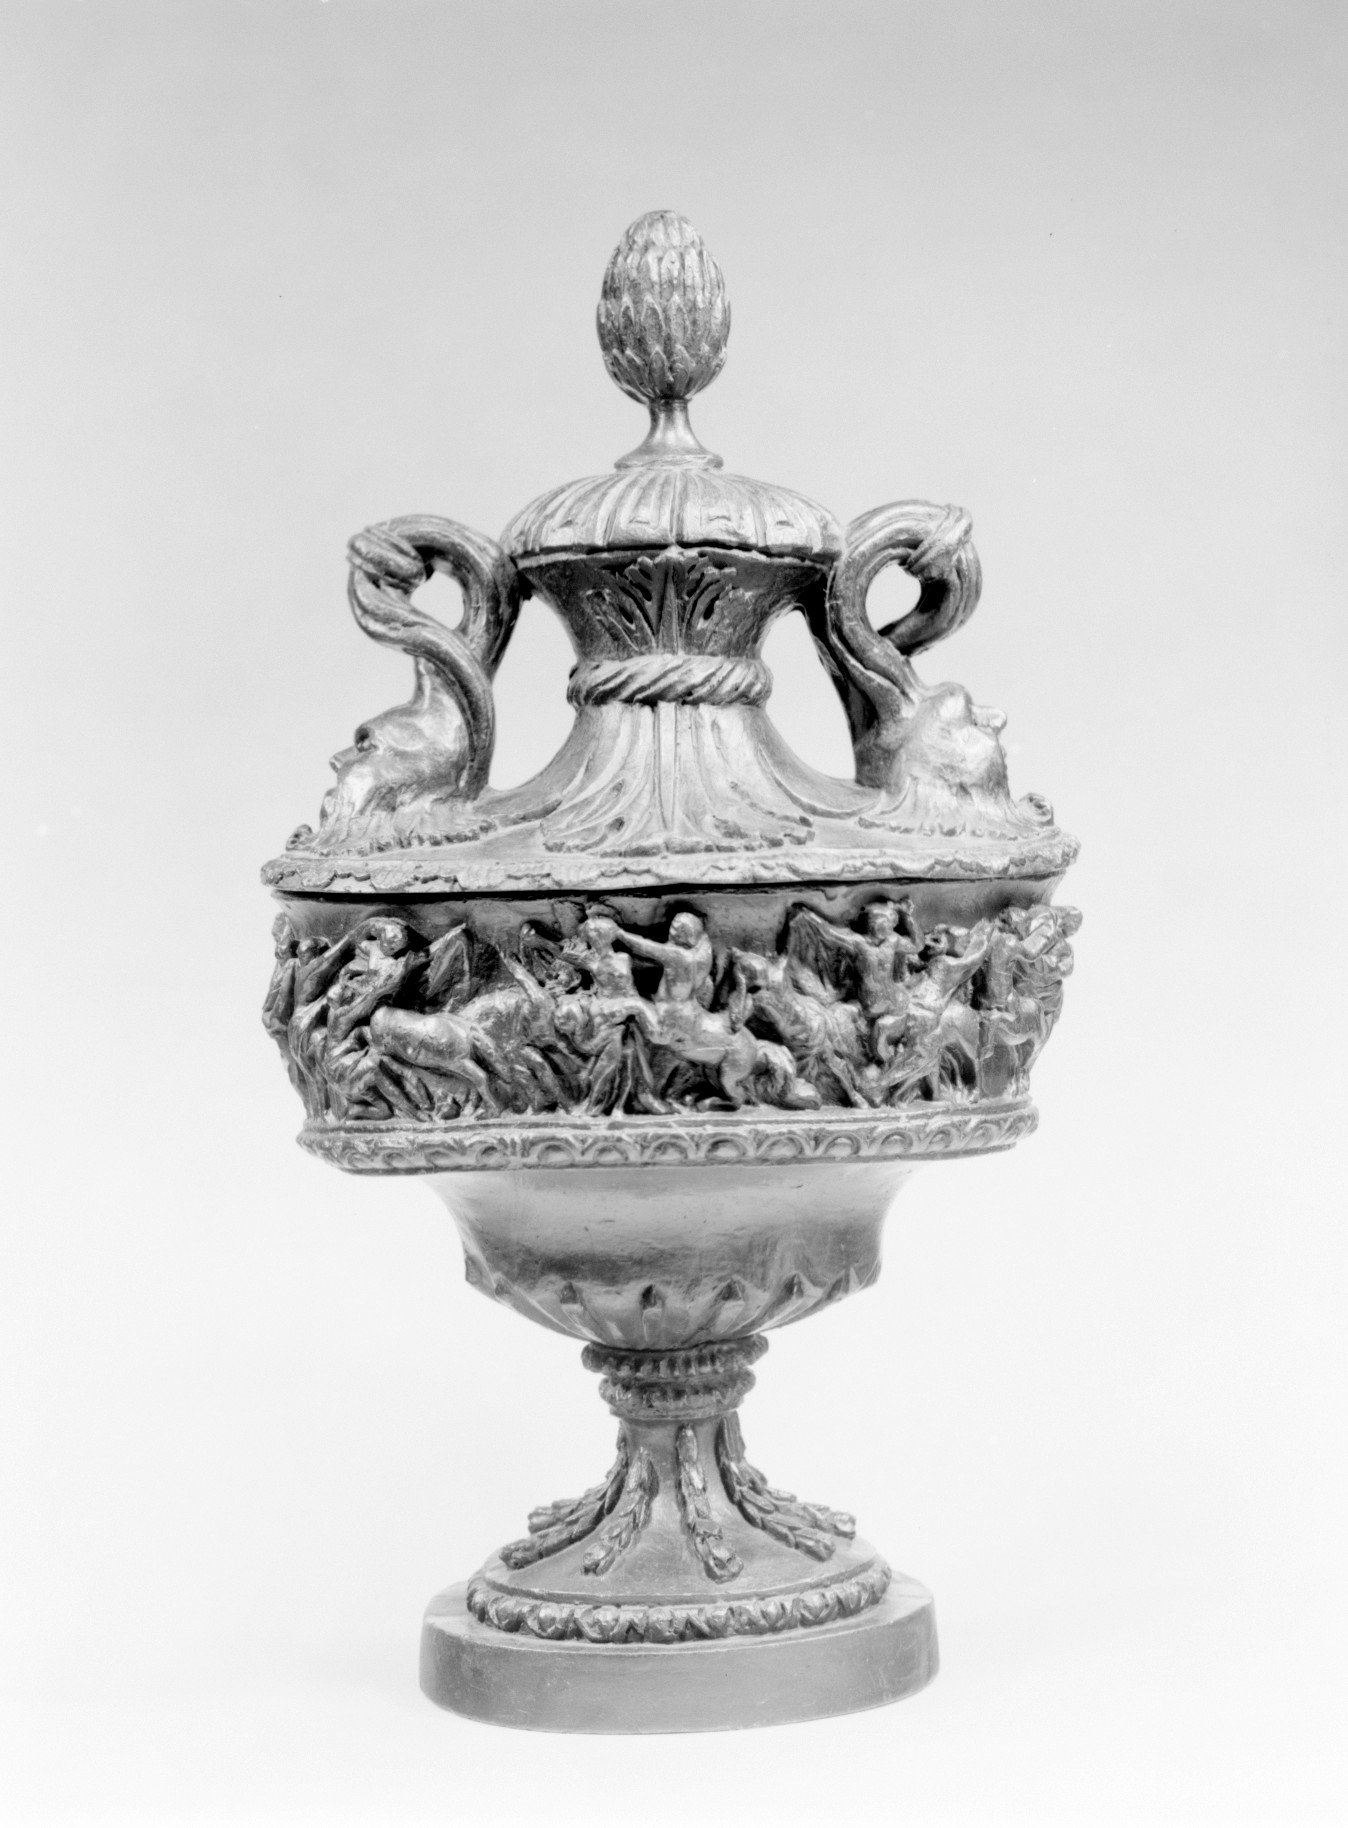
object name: vase with cover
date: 1801-1900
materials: wood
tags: heads,griffins